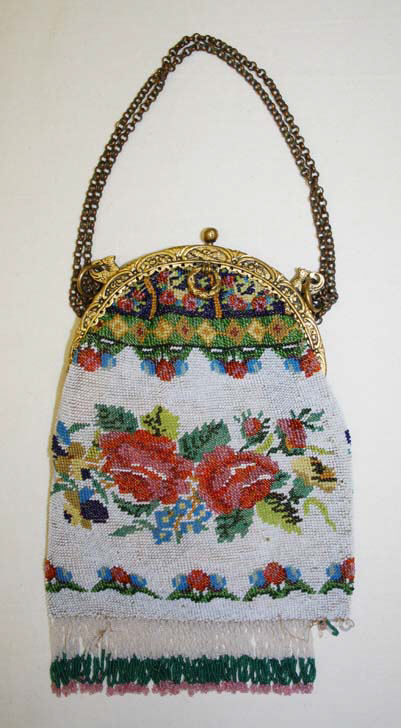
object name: purse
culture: german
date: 1820-1829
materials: glass, metal, wool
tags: flowers